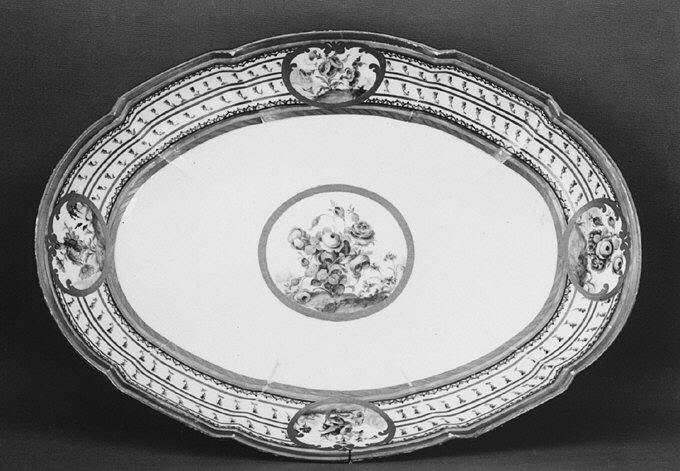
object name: fruit dish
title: Fruit dish (compotier ovale)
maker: sèvres manufactory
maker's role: manufactory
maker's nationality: french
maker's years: 1740-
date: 1783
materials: soft paste porcelain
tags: flowers